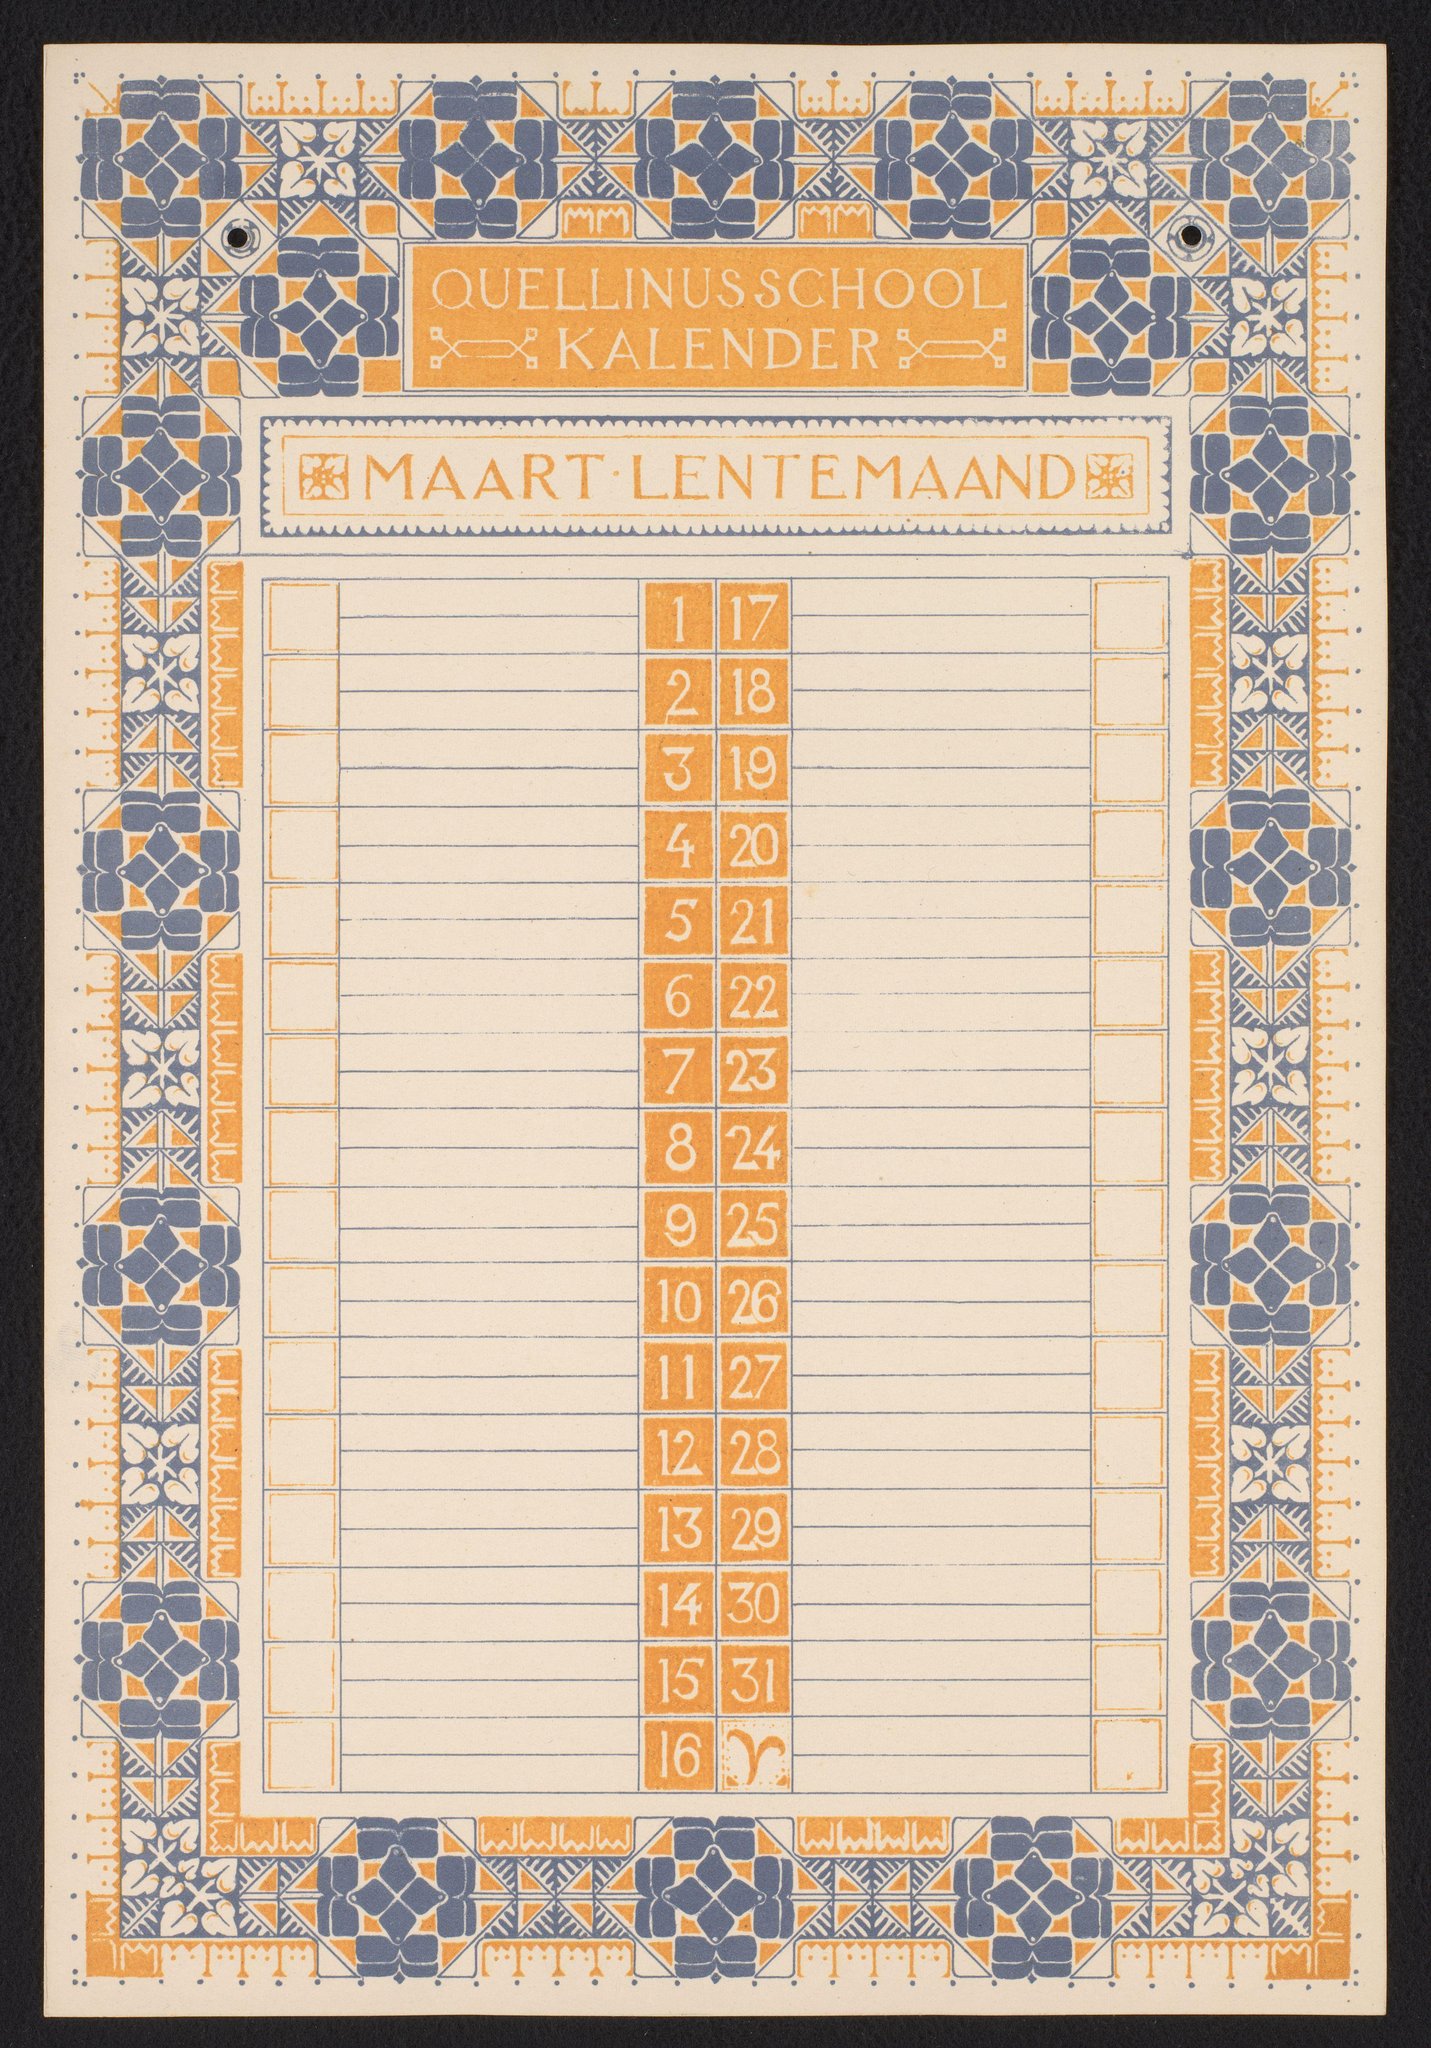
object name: print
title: Kalenderblad voor de lentemaand, maart, van een kalender van Kunstnijverheidsschool Quellinus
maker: Anonymous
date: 1885-1925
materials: paper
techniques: lithograph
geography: amsterdam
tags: flowers, ornaments ~ art, calendar, almanac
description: Bij gebrek aan gegevens over de vervaardiger is voor de bepaling van de rechten van dit object gebruik gemaakt van de vervaardigingsdatum.